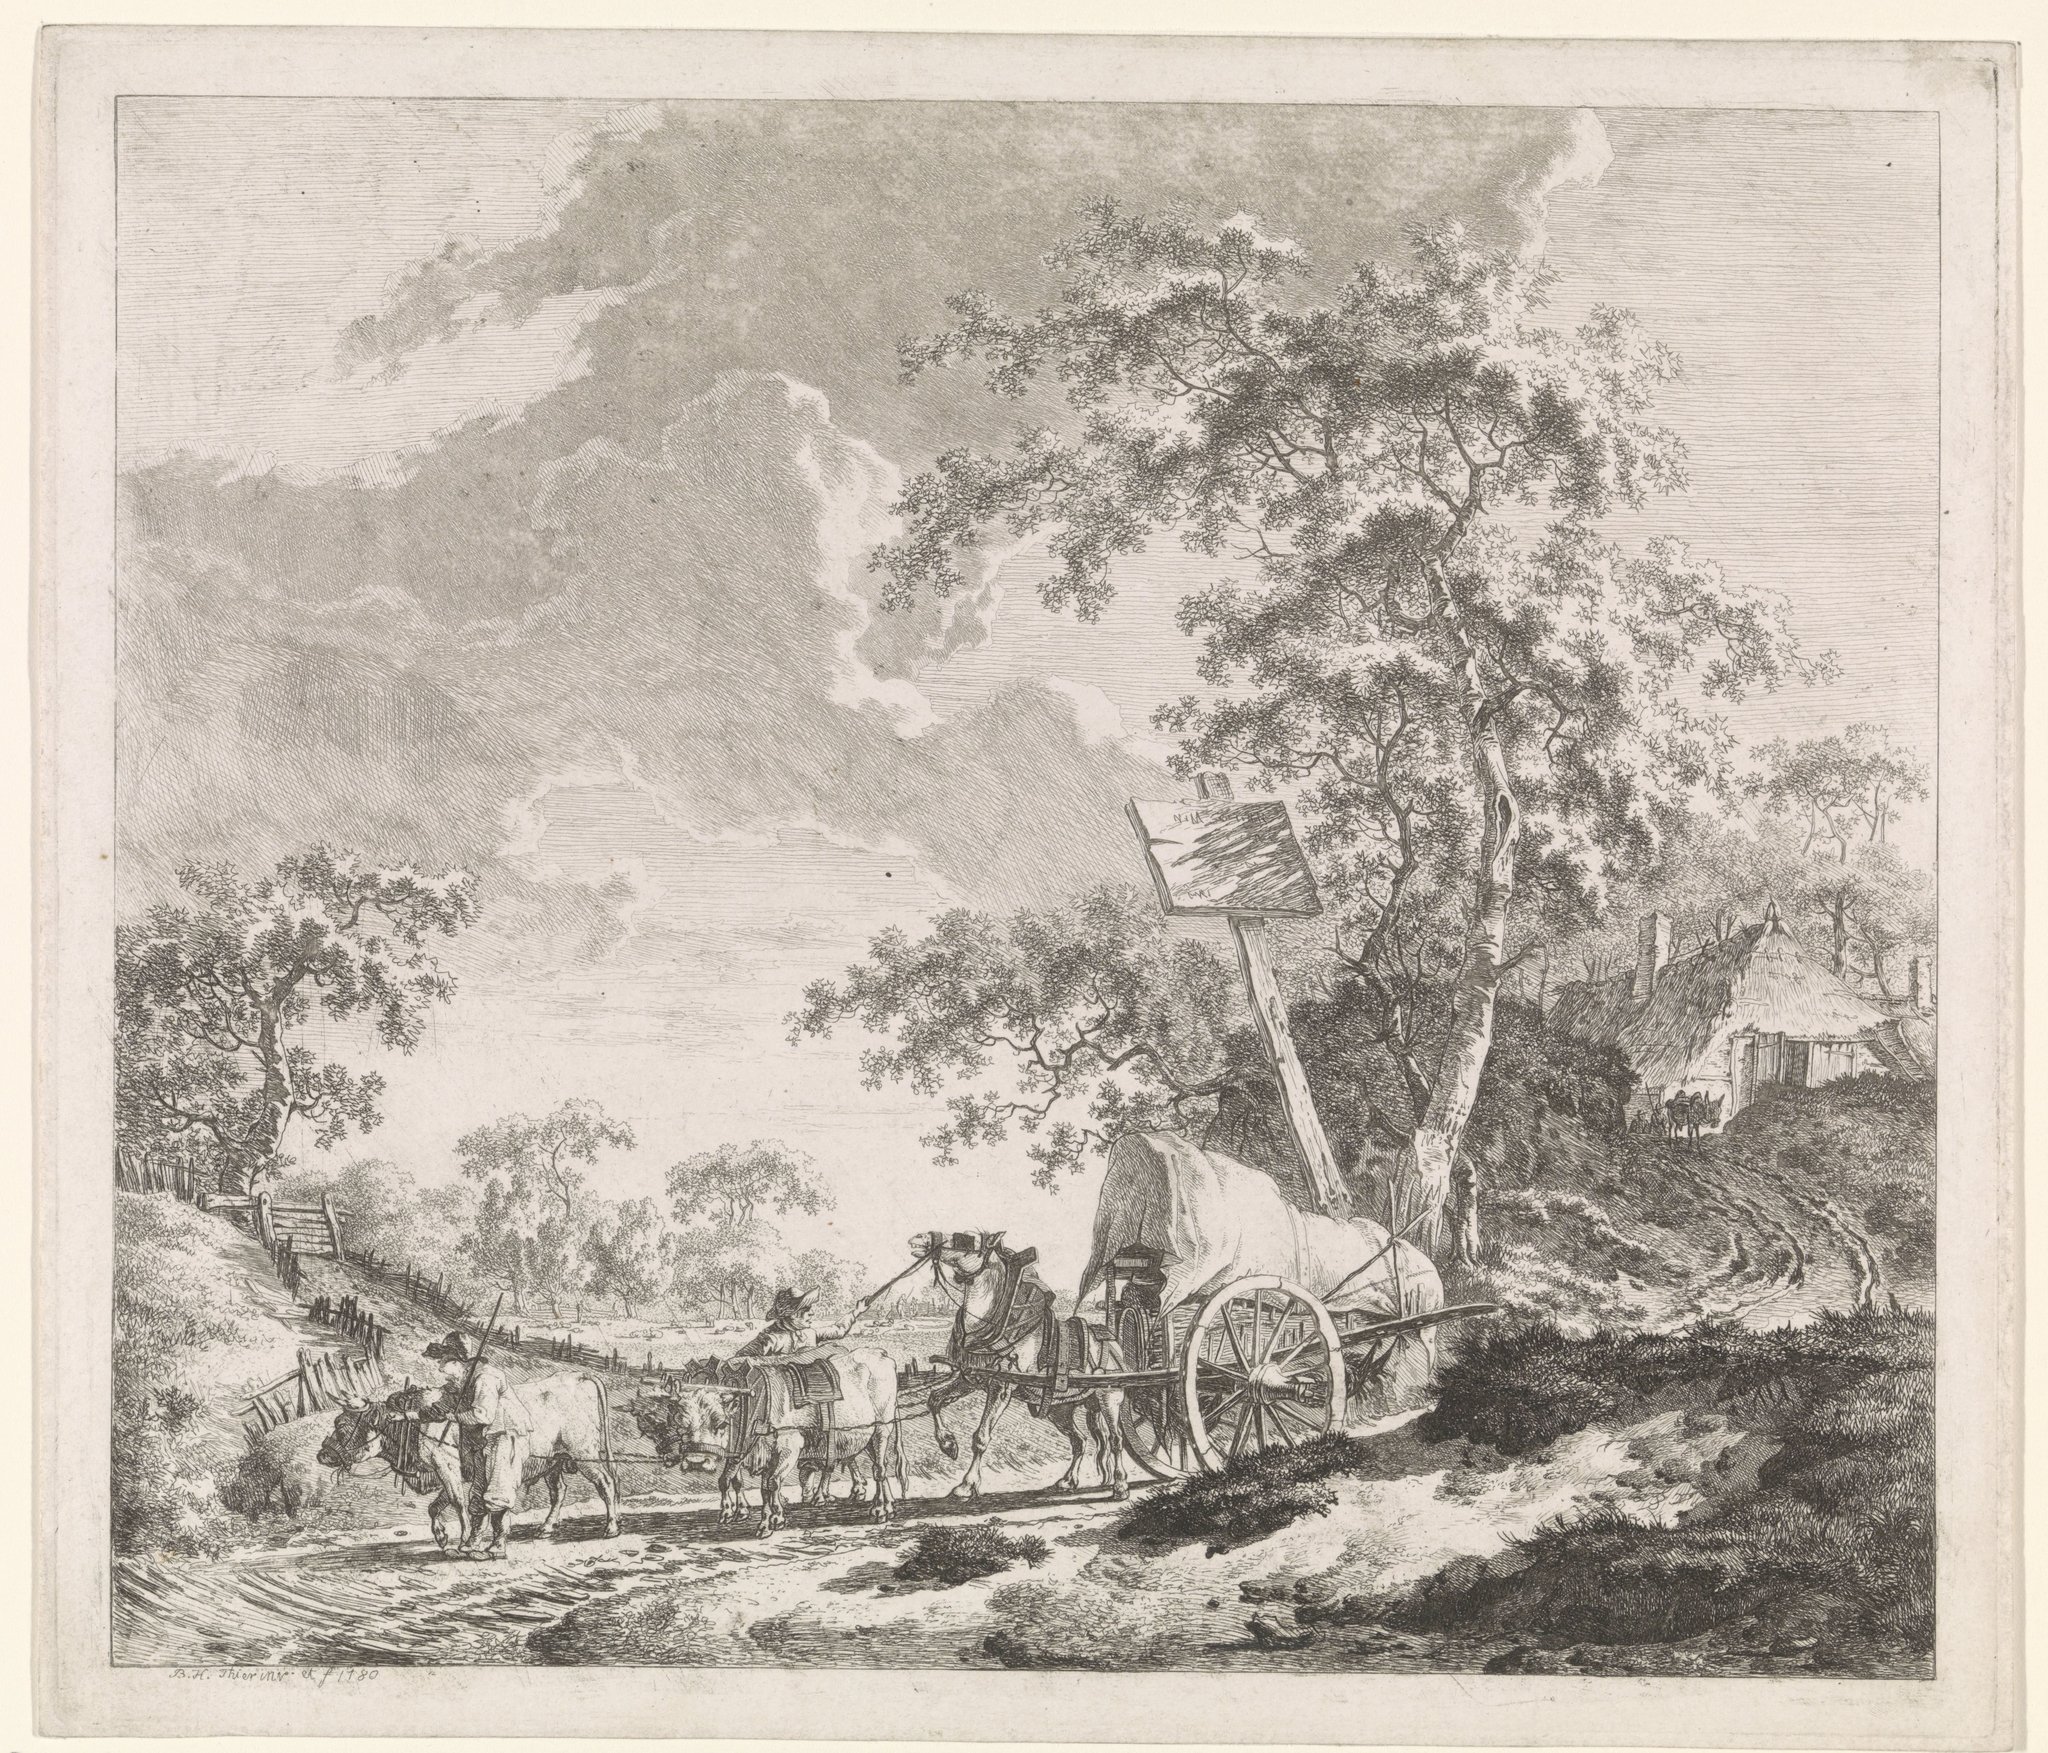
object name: print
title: Landschap met ingespannen runderen en een paard die een kar trekken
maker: barend hendrik thier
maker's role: draughtsman, print maker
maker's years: 1743-1811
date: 1780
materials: paper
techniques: etching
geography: netherlands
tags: horse, ox, (farm) wagon, freight wagon, cart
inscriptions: collector's mark: Lugt 2228, collector's mark: Lugt 2760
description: Landschap met twee boeren bij een kar, die wordt getrokken door drie ossen en een paard. Rechtsachter een ezel bij een boerderij.